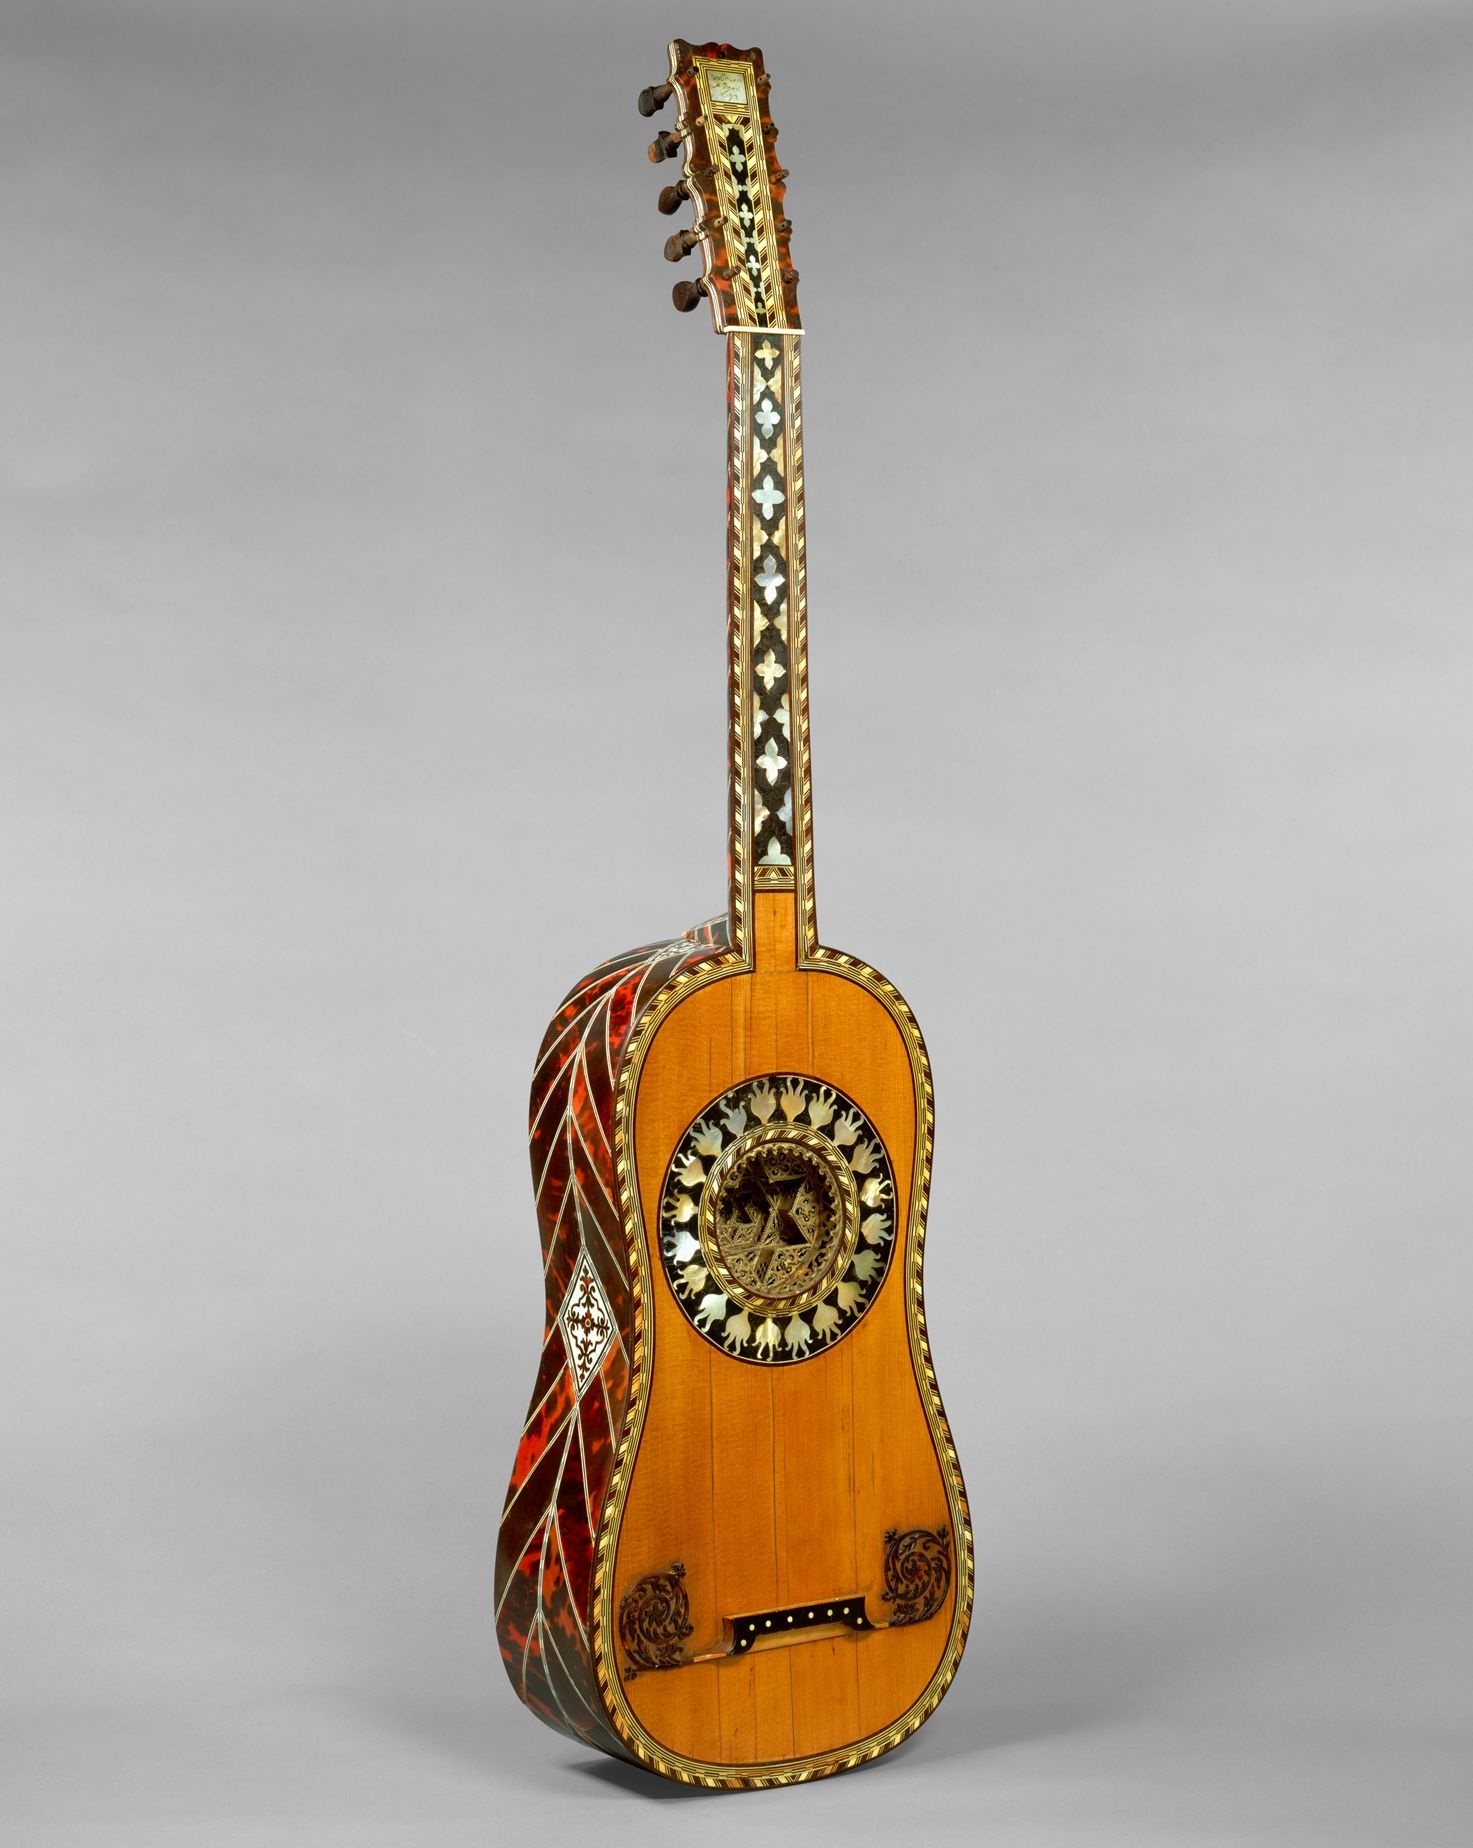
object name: guitar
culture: french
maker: jean-baptiste voboam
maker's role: maker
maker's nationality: french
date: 1697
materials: wood, ivory, mother of pearl, shell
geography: france